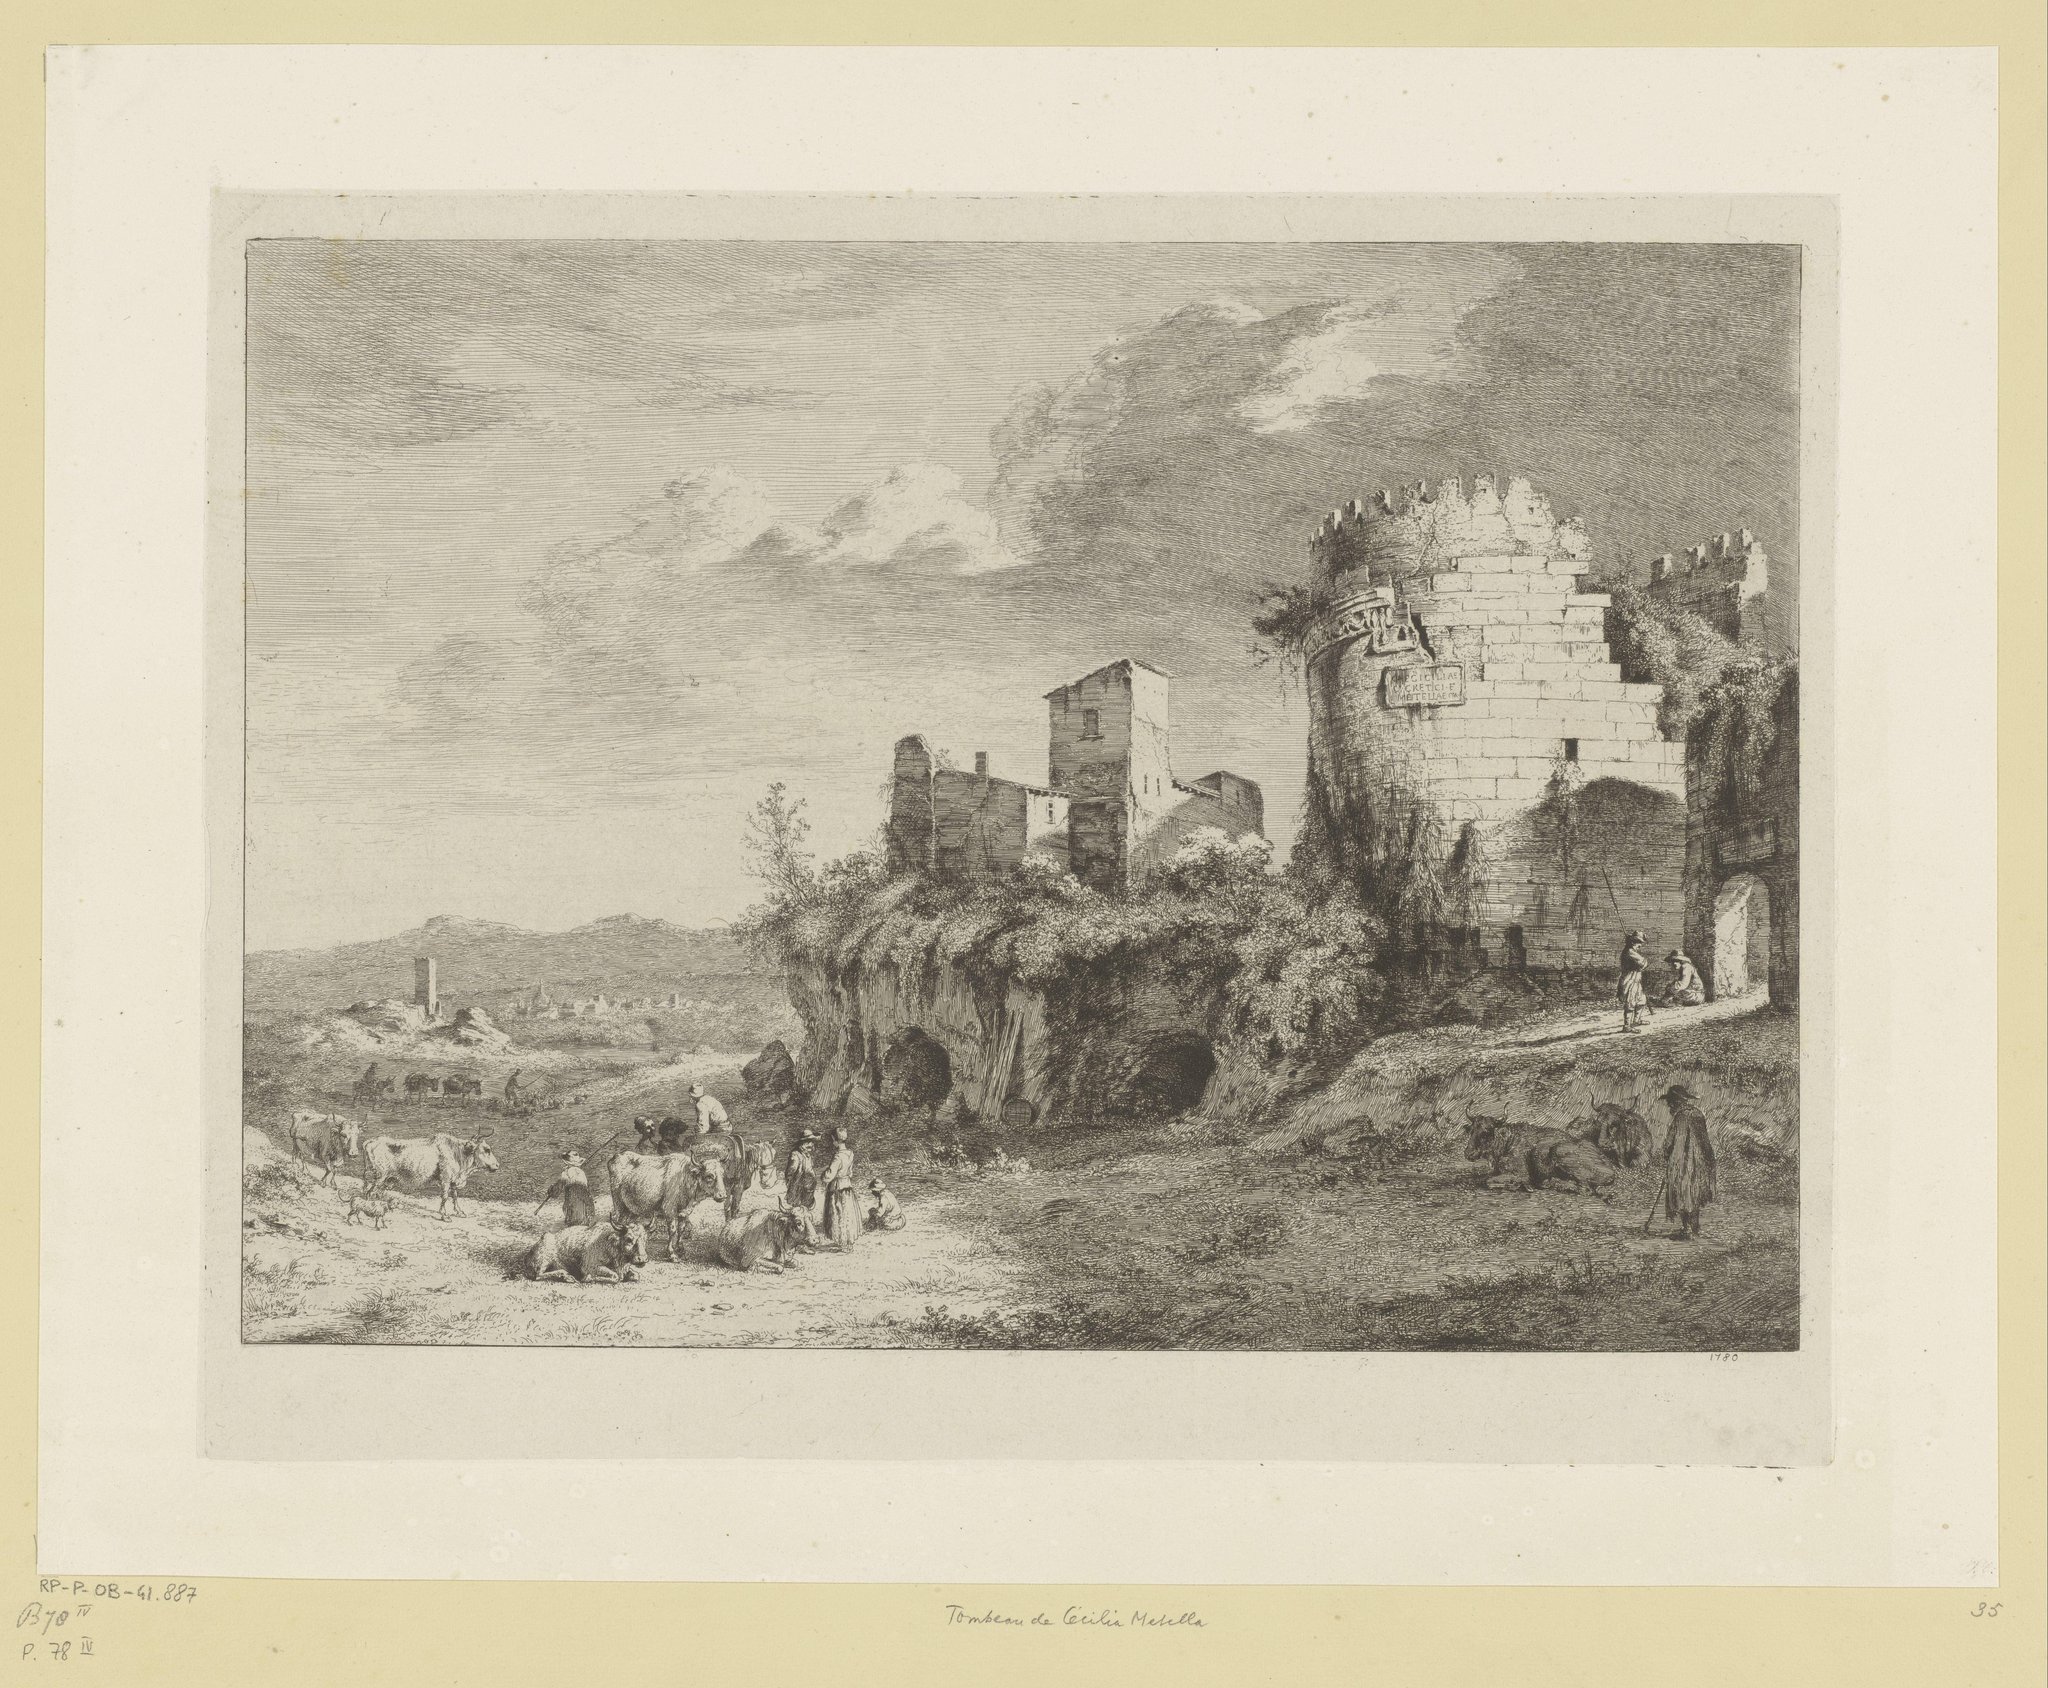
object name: print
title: Landschap met een gezicht op de tombe van Caecilia Metella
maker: jean jacques de boissieu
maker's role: draughtsman, print maker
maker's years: 1736-1810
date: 1780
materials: paper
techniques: drypoint, etching, roulette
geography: france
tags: herding, herdsman, herdswoman, shepherd, shepherdess, cowherd, etc., landscape with ruins, grave, tomb, herd, flock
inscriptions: collector's mark: Lugt 12